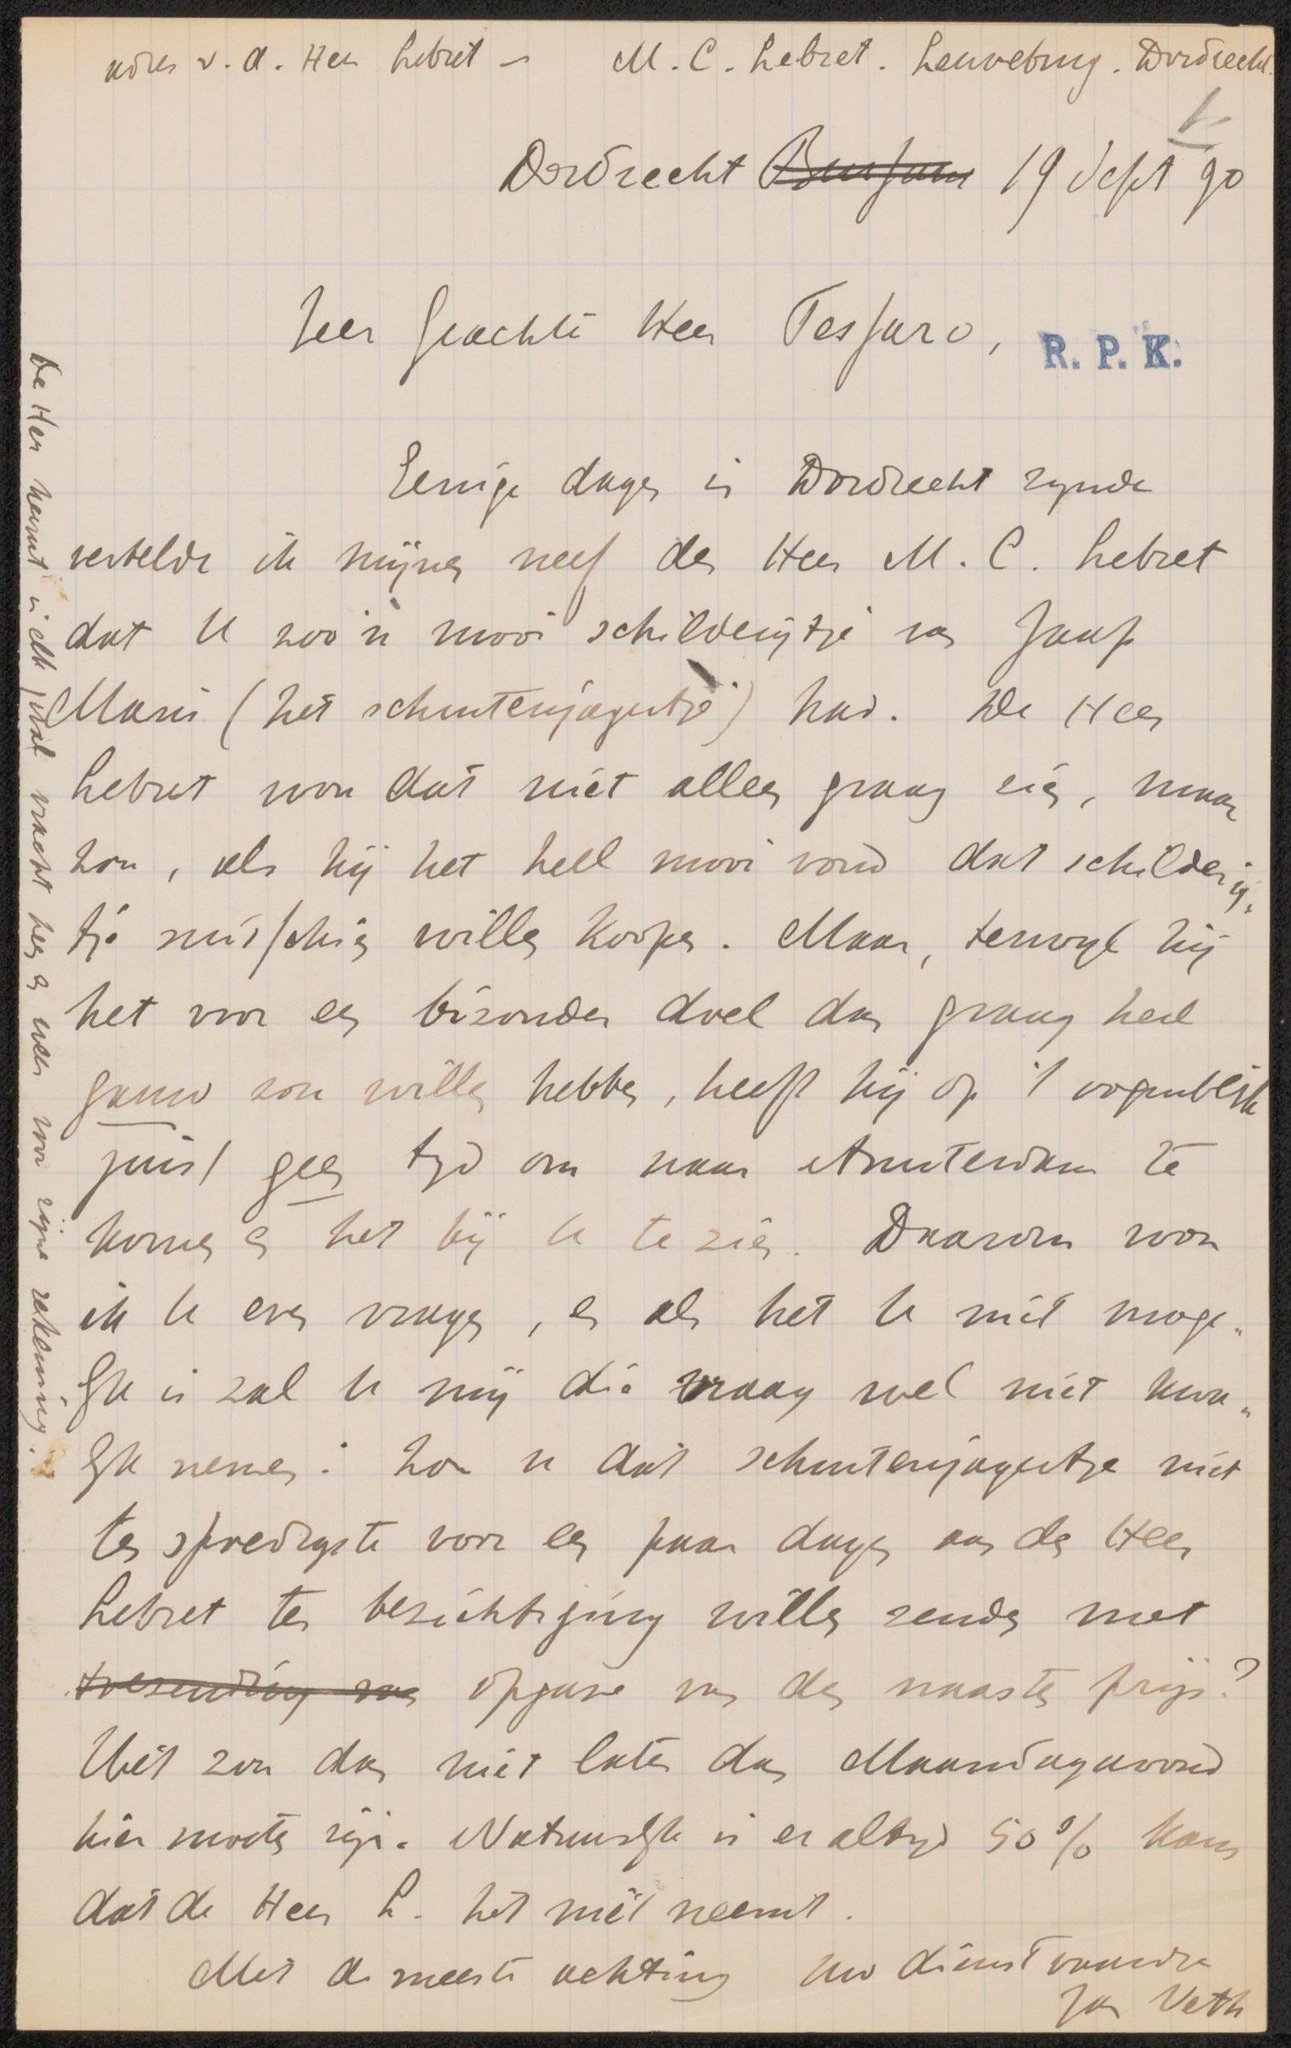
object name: letter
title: Brief aan Filippo Tessaro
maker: jan veth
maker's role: designer, draughtsman, painter, print maker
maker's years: 1864-1925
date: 1890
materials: ink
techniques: pen, writing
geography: dordrecht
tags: the hague, painter, print maker, draughtsman, jacob maris, martinus cornelis lebret, art trade, art shop, painting (including book-illumination, miniature-painting), dordrecht, amsterdam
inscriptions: collector's mark: Lugt 2233